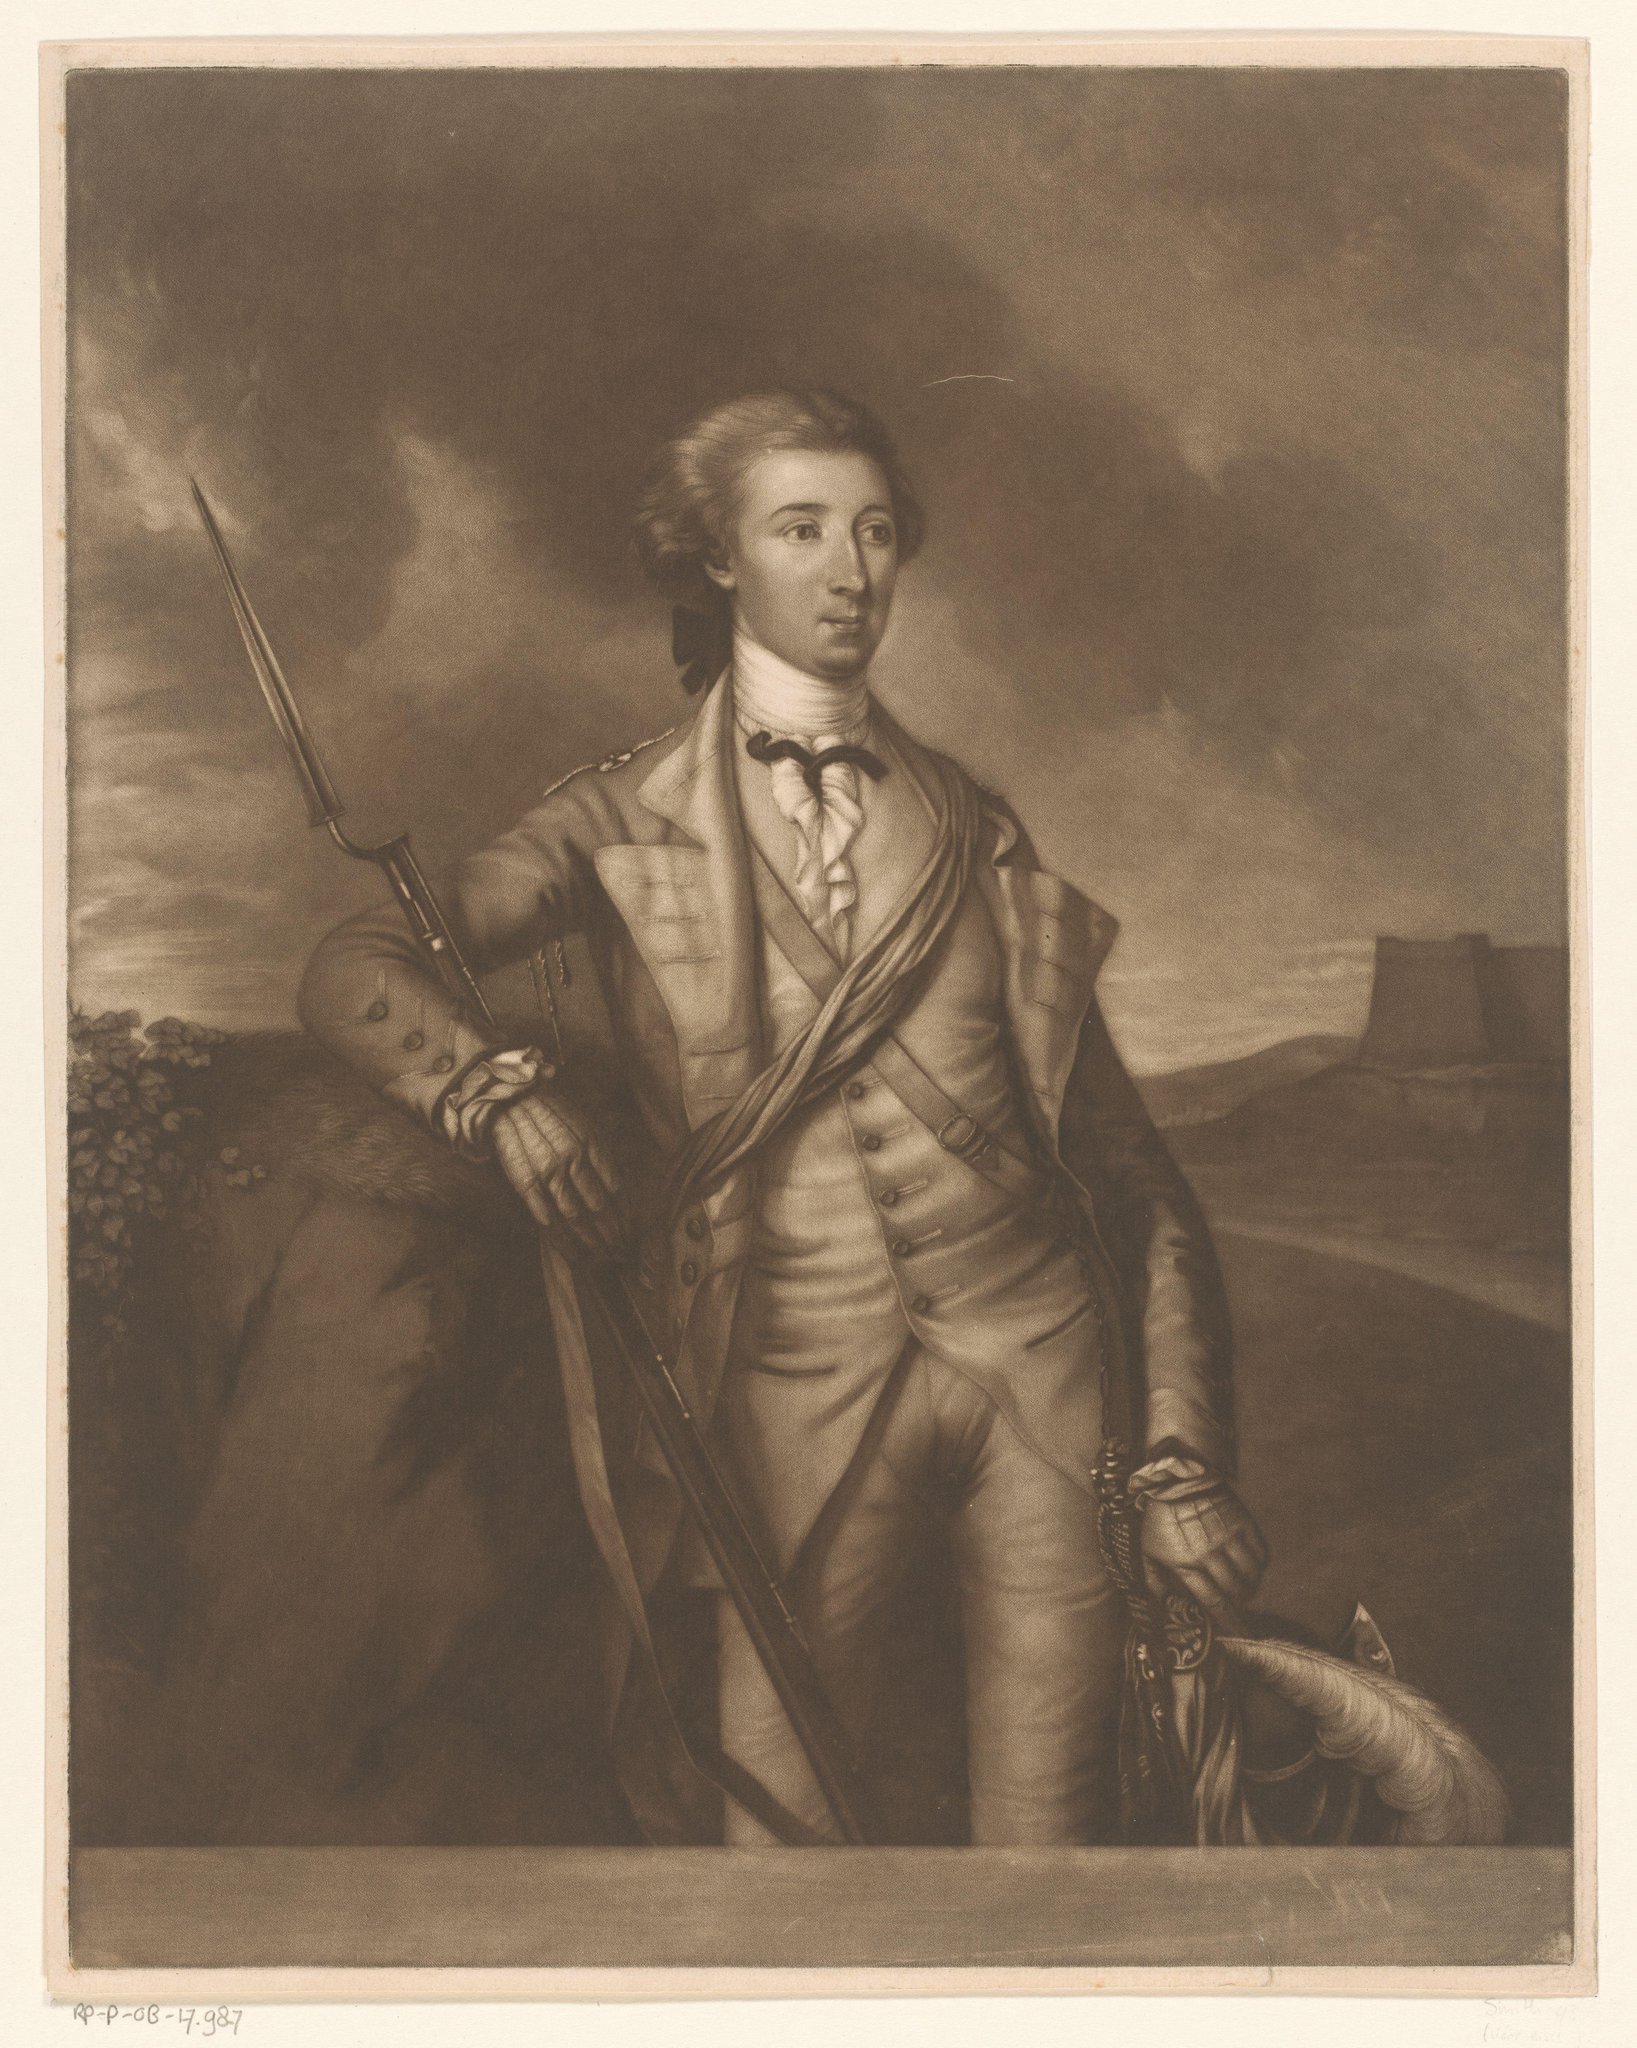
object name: print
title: Portret van William Kerr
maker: edward fisher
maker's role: print maker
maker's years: 1722-1785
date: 1762-1769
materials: paper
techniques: mezzotint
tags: historical persons, the soldier; the soldier's life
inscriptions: collector's mark: Lugt 240